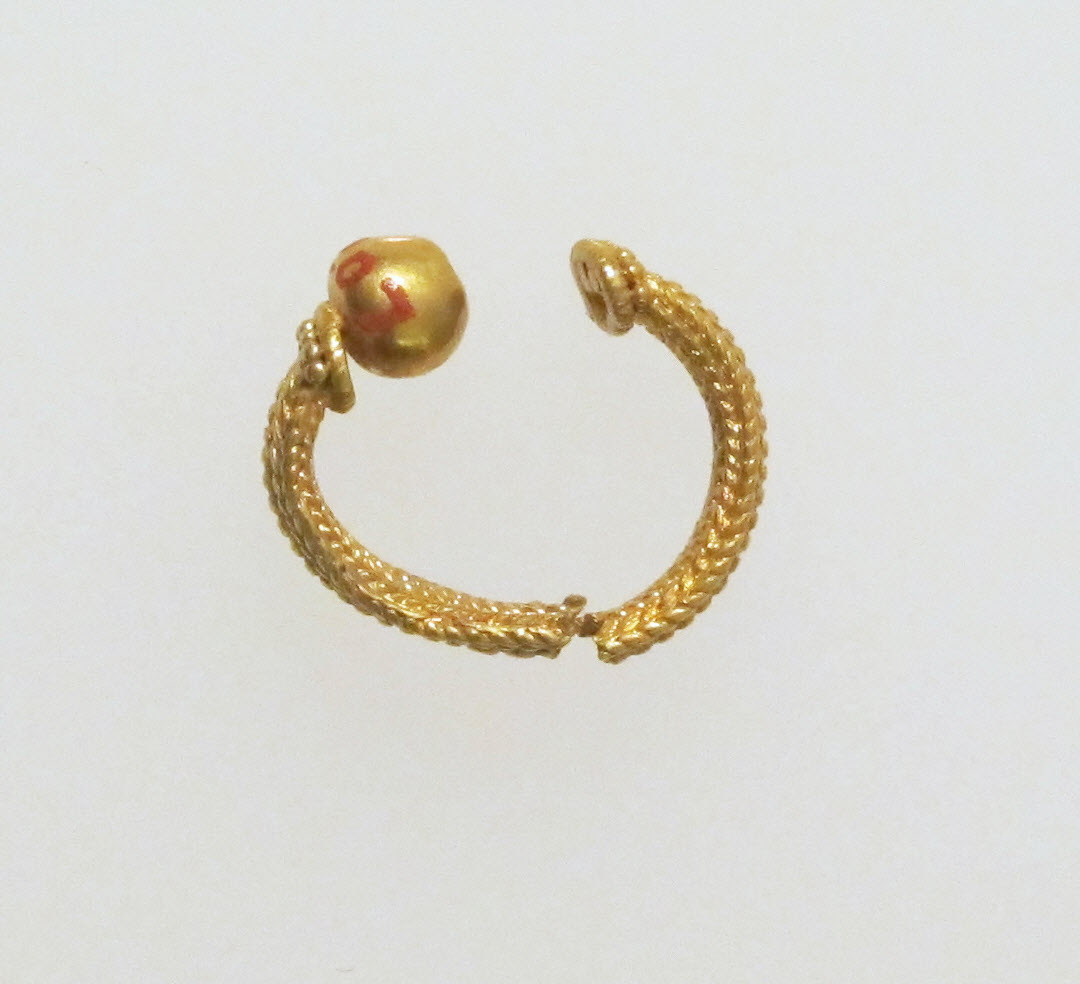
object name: earring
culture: etruscan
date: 900-100 BCE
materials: gold